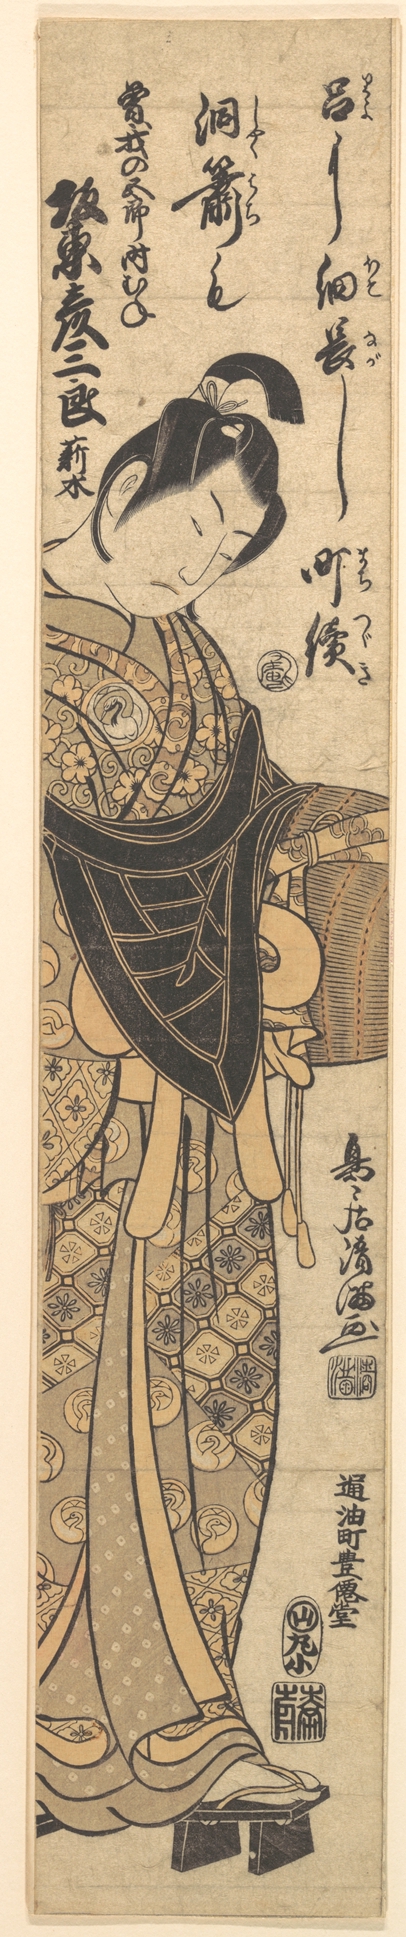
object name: print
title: The Actor Bandō Hikosaburō II as a Komuso in the Role of Sōga no Gorō Tokimune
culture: japanese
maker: torii kiyomitsu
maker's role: artist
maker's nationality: japanese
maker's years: 1735-1785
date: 1764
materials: ink, paper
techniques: woodblock print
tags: men,actors